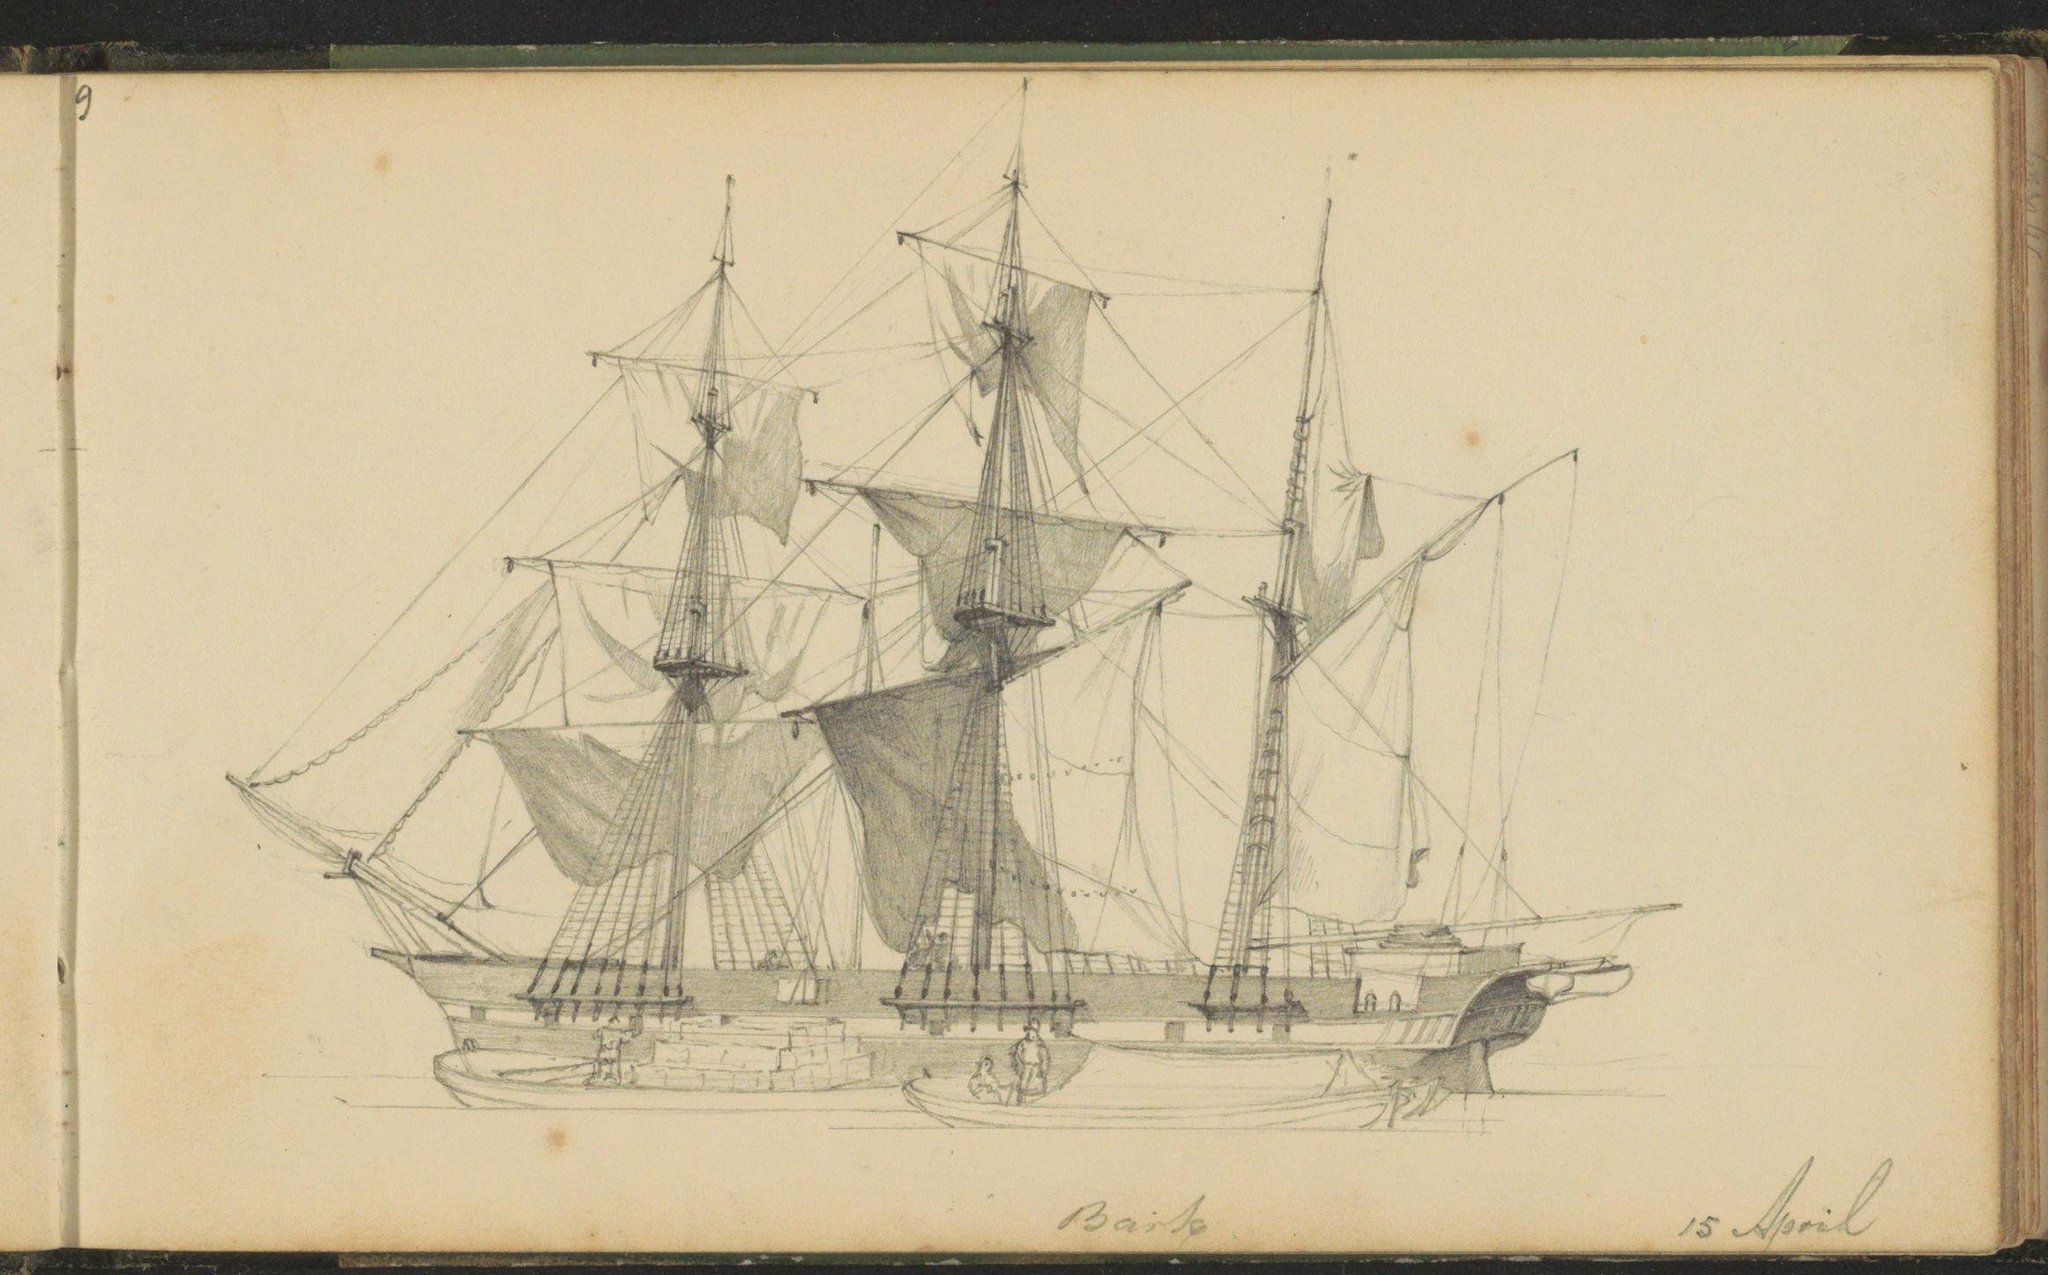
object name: sketchbook leaf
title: Bark aan een kade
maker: hendrik abraham klinkhamer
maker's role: draughtsman, painter, print maker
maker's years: 1810-1872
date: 1804-1843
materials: paper, pencil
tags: sailing-ship, sailing-boat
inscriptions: date and inscription: ‘Bark 15 April’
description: Op de voorgrond twee roeiboten met figuren en transportwaren. Blad 9 recto uit een schetsboek met 40 bladen.